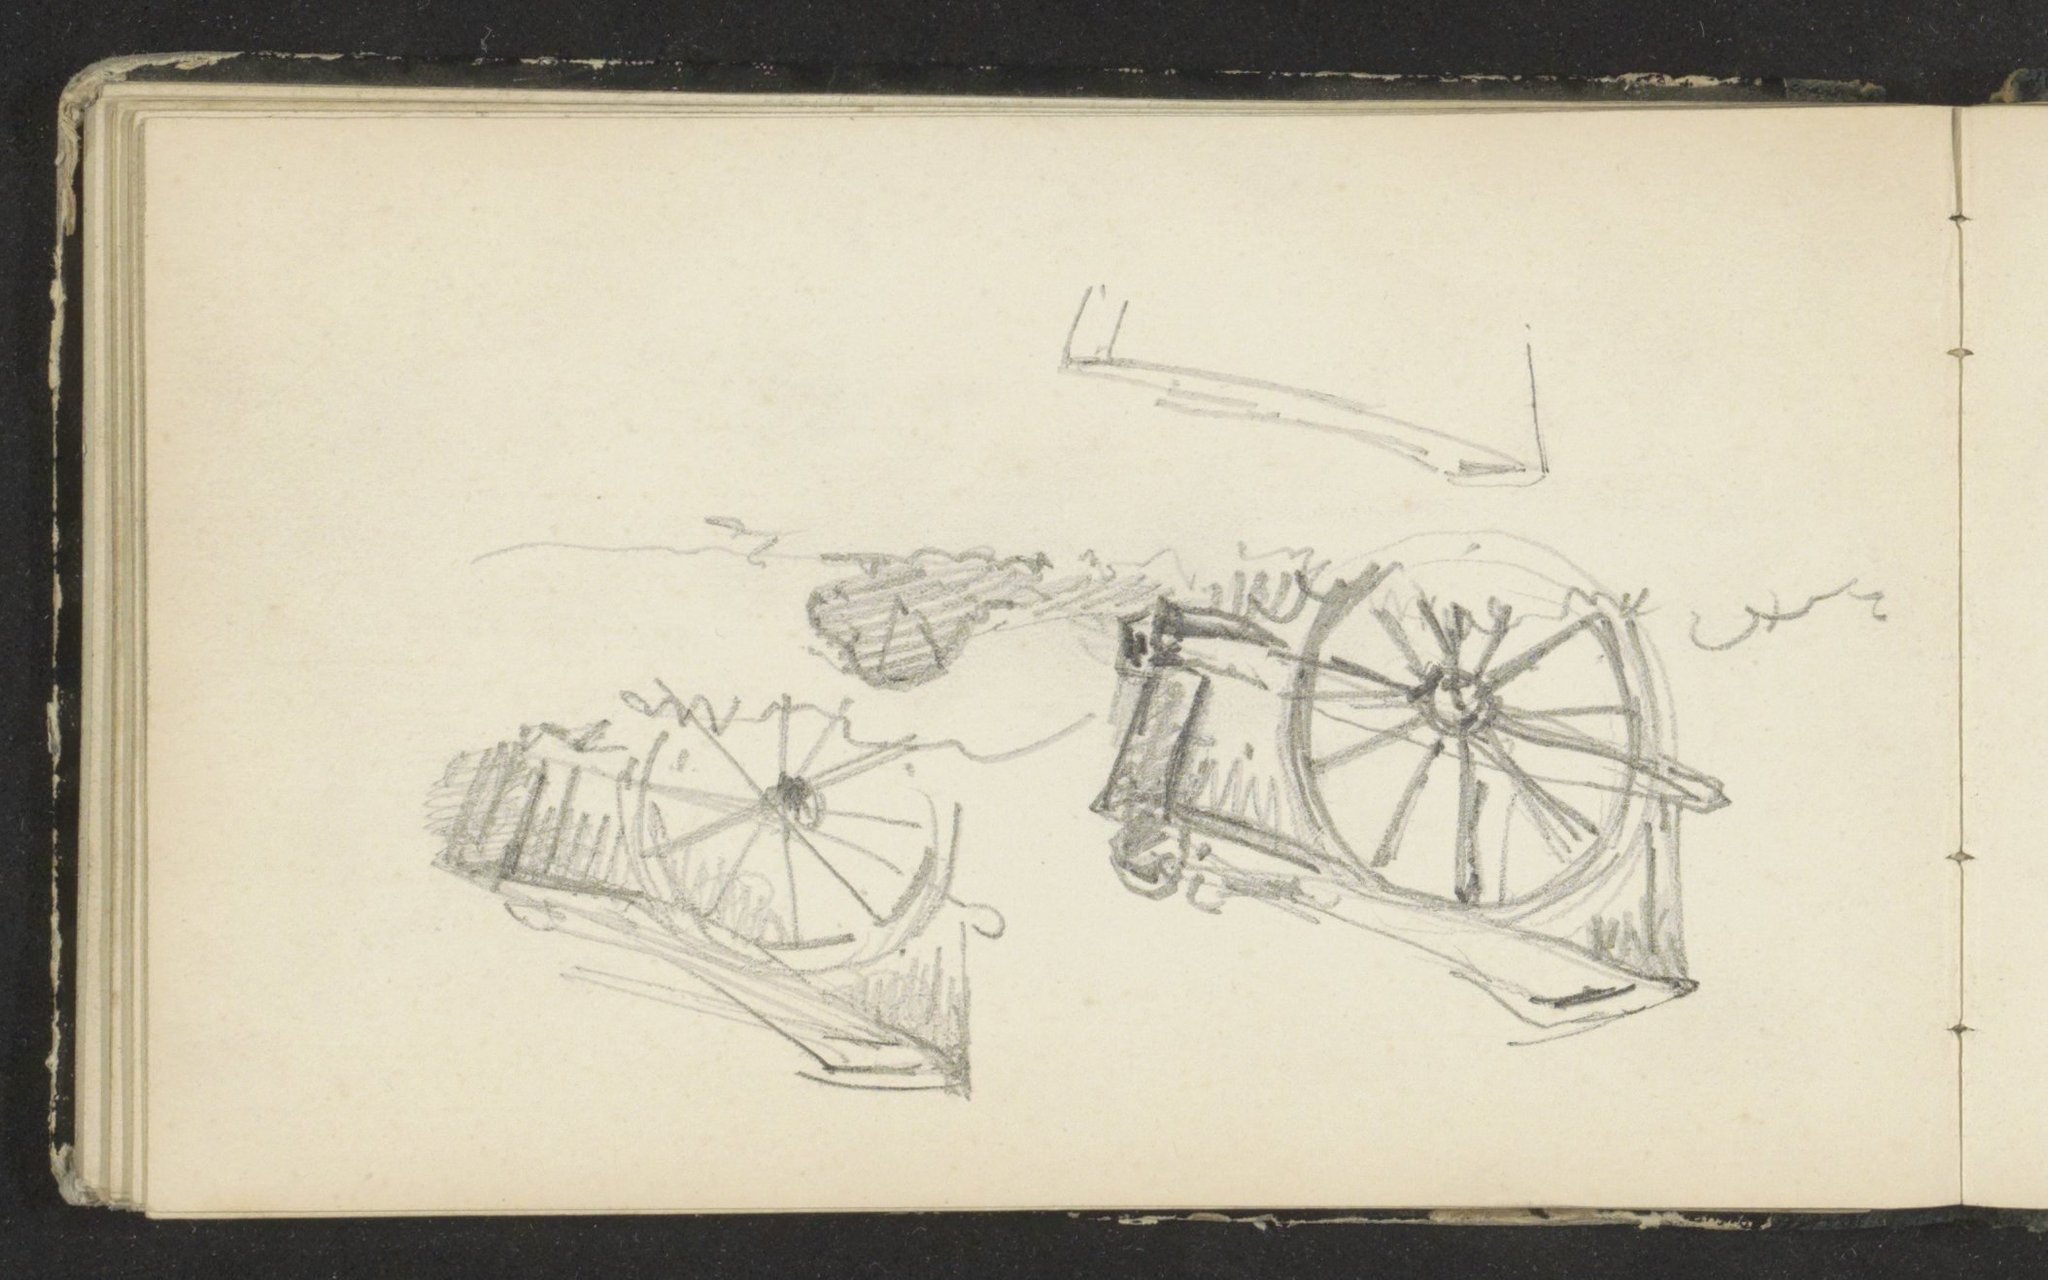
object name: sketchbook leaf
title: Karren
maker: maria vos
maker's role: draughtsman, painter, print maker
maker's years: 1824-1906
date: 1834-1906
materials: paper, pencil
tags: hand-cart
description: Blad 31 verso uit een schetsboek met 46 bladen.